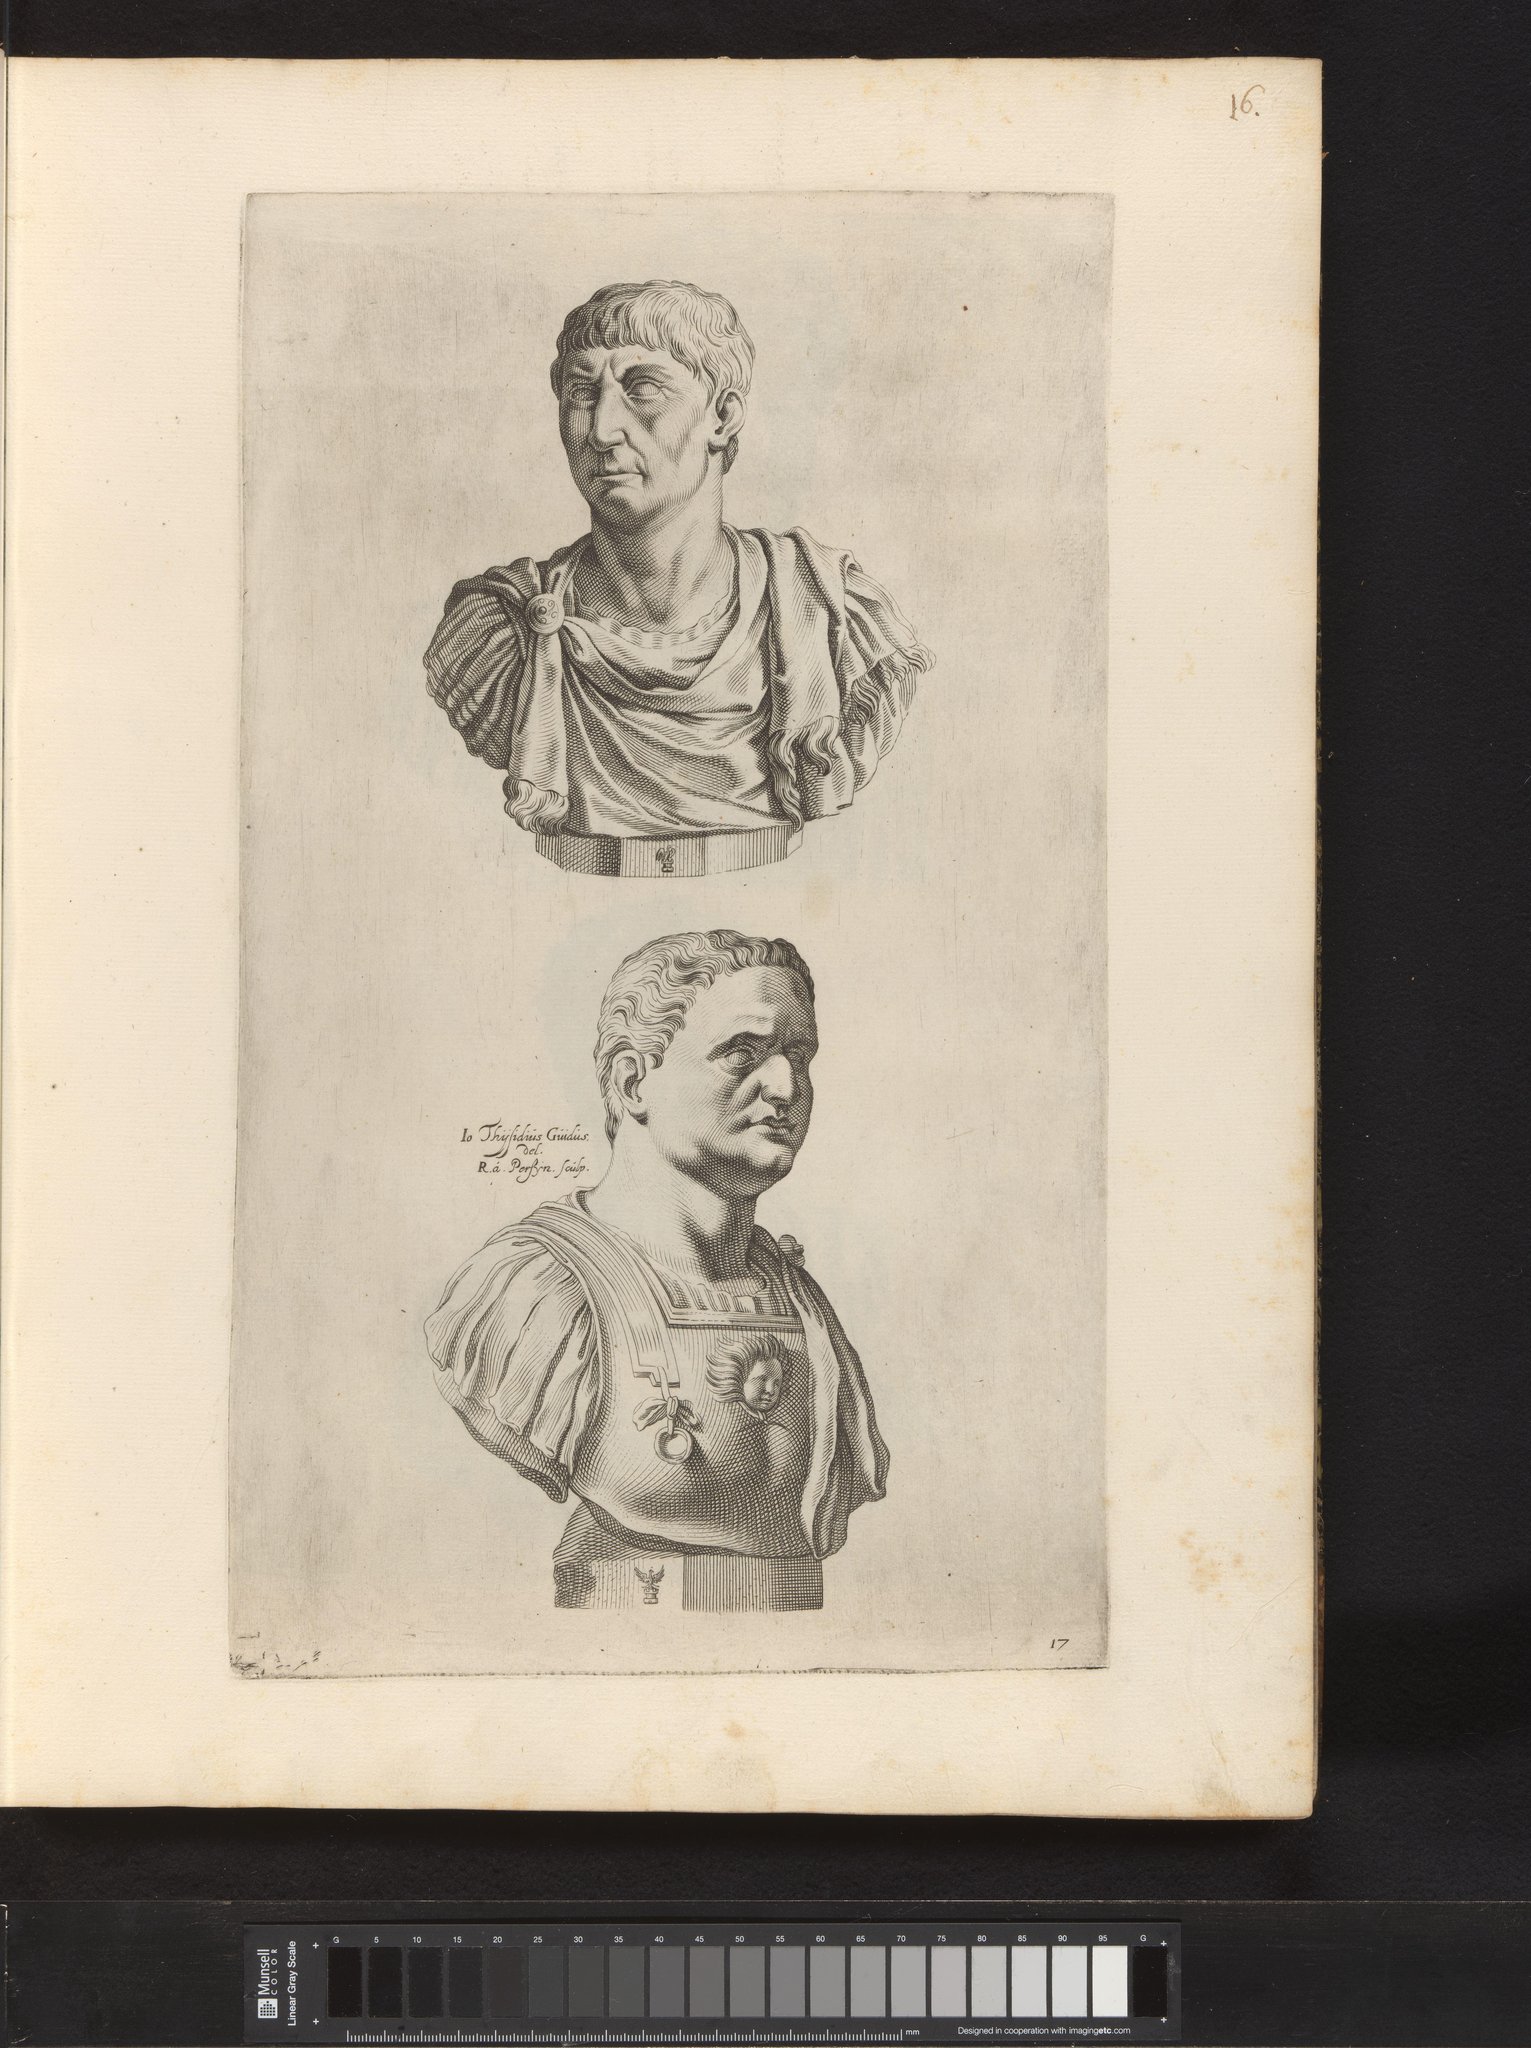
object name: print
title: Galleria Giustiniana del Marchese Vincenzo Giustiniani II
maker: theodor matham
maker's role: draughtsman, print maker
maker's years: 1605-1676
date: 1636-1647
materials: paper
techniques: engraving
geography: rome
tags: male persons from classical history (+ head, bust, etc.), piece of sculpture, reproduction of a piece of sculpture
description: Twee bustes van Romeinen. Boven de buste van keizer Pupienus en onder mogelijk van keizer Balbinus. Op de bustes het wapenschild van Vincenzo Giustiniani. Prent maakt deel uit van een album met een serie prenten naar de sculpturen in de verzameling in de Galleria Giustiniani te Rome.